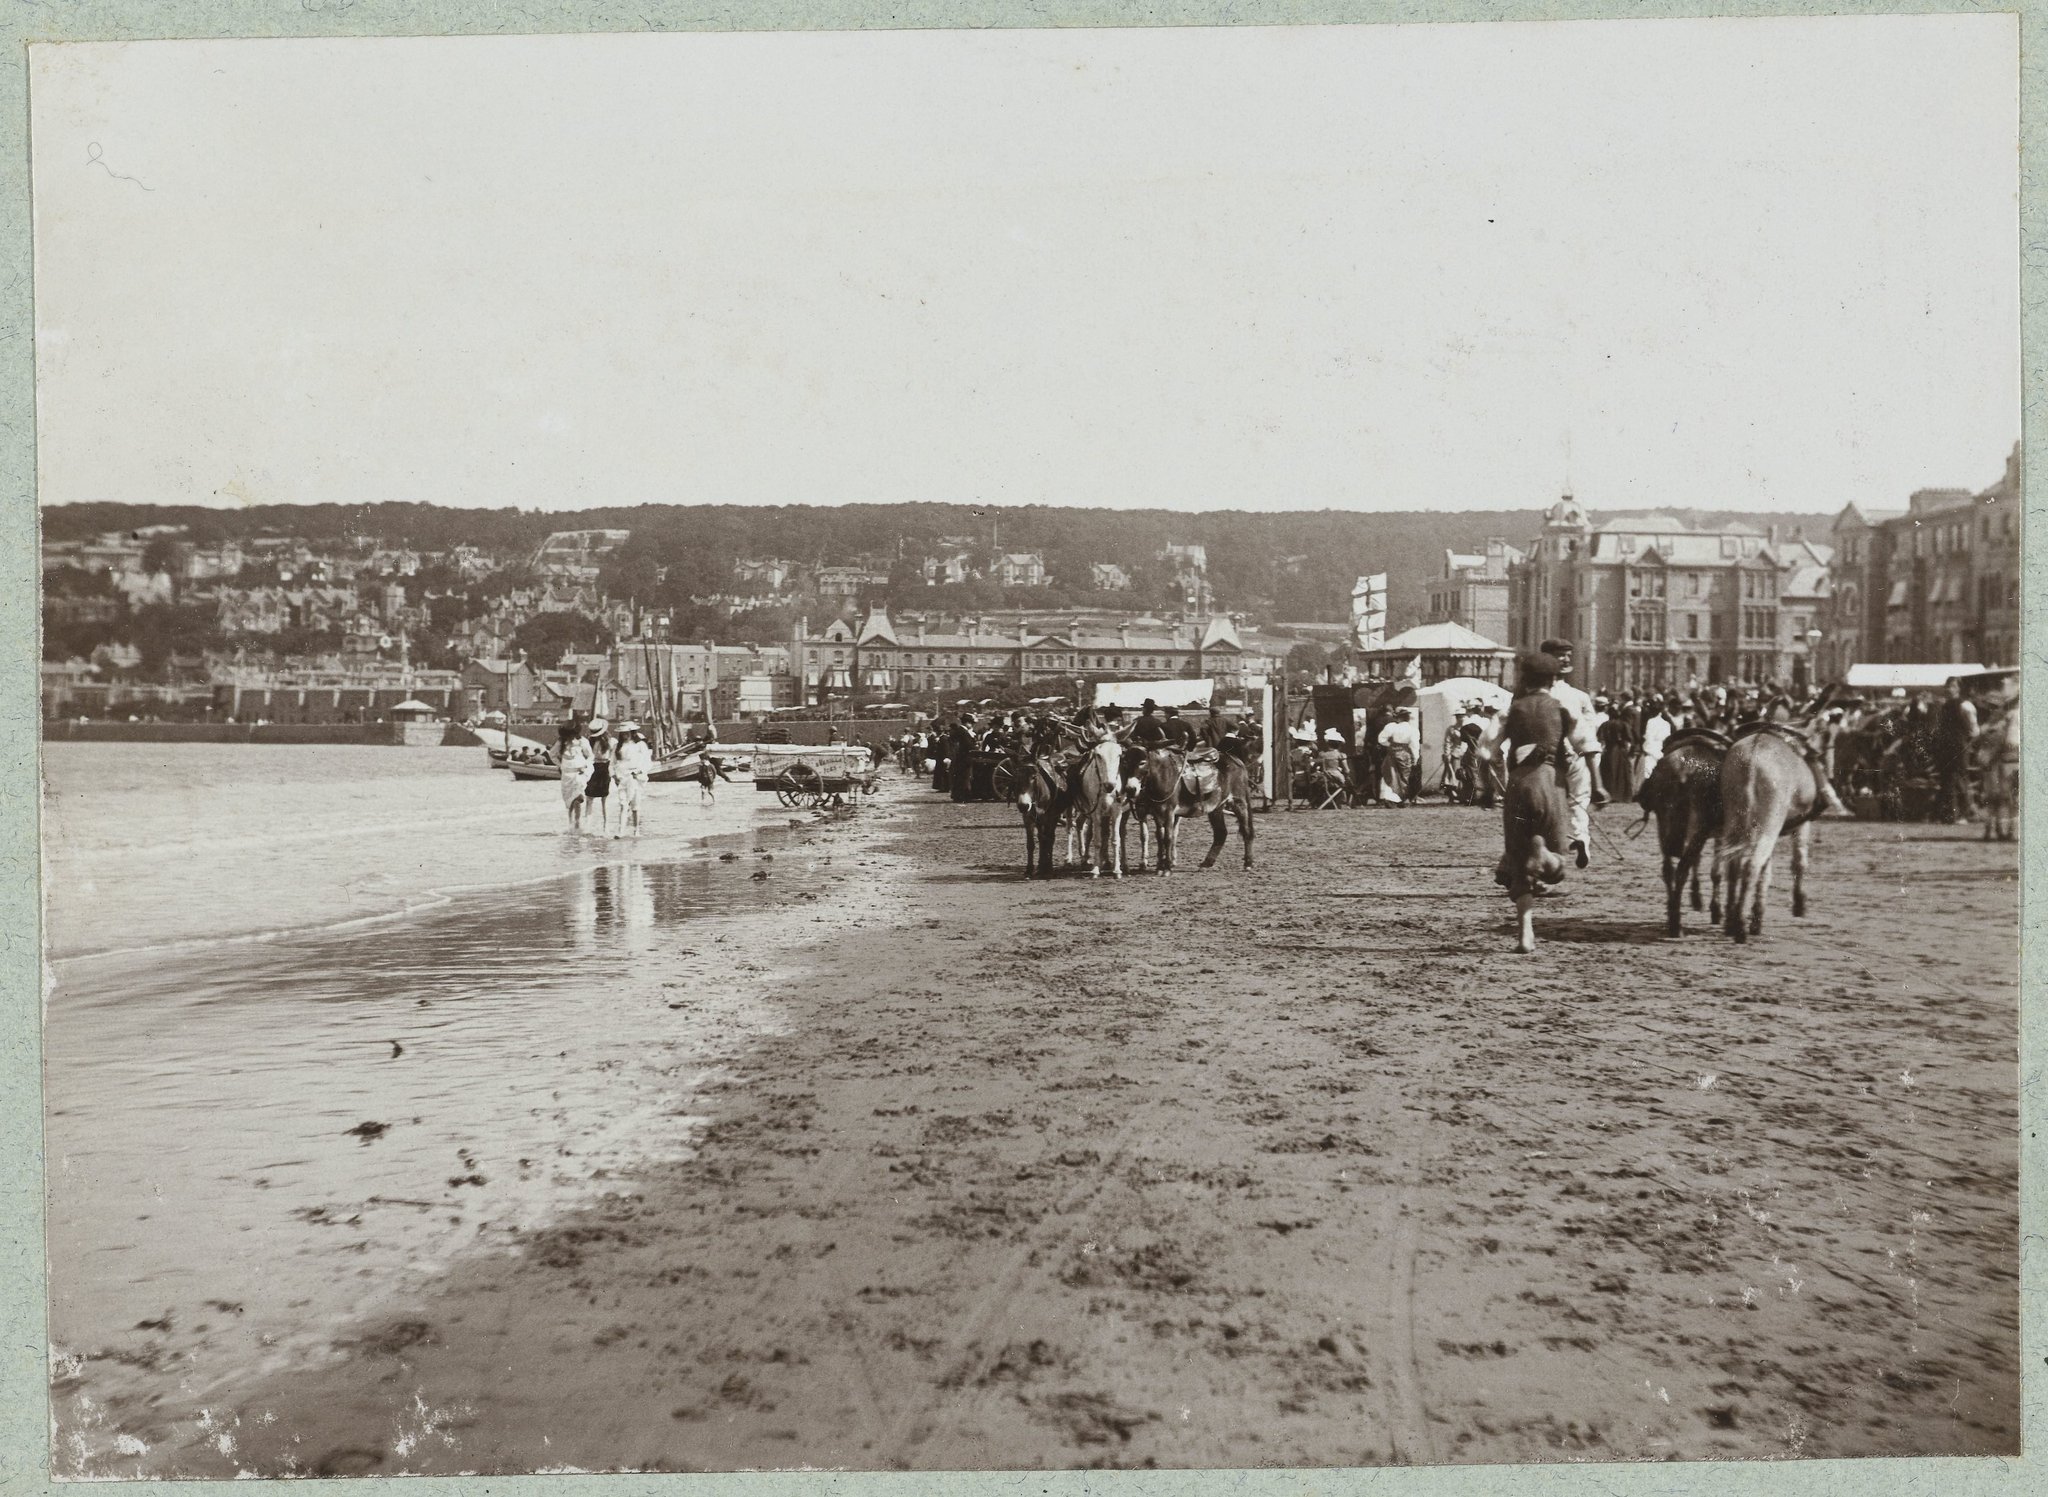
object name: photograph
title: Weston-Super-Mare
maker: frits freerks fontein fz.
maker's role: fotograaf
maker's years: 1882-1928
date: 1901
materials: cardboard, paper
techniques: gelatin silver print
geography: netherlands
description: Weston-Super-Mare is een badplaats in Groot-Brittannië. Foto uit album 'Photographieën".